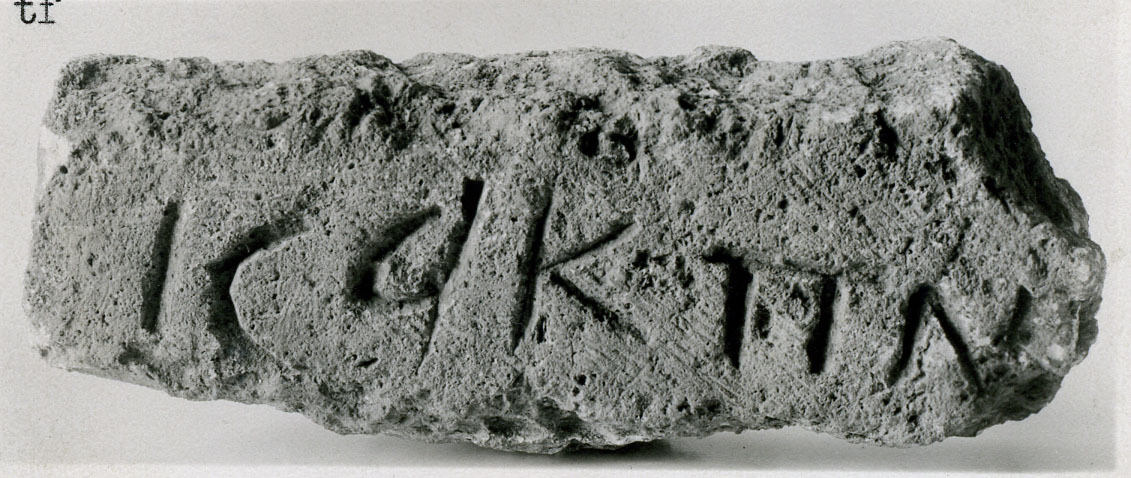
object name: stele fragment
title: Fragment of an Inscribed Stele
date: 701-1000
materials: limestone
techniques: incising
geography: egypt